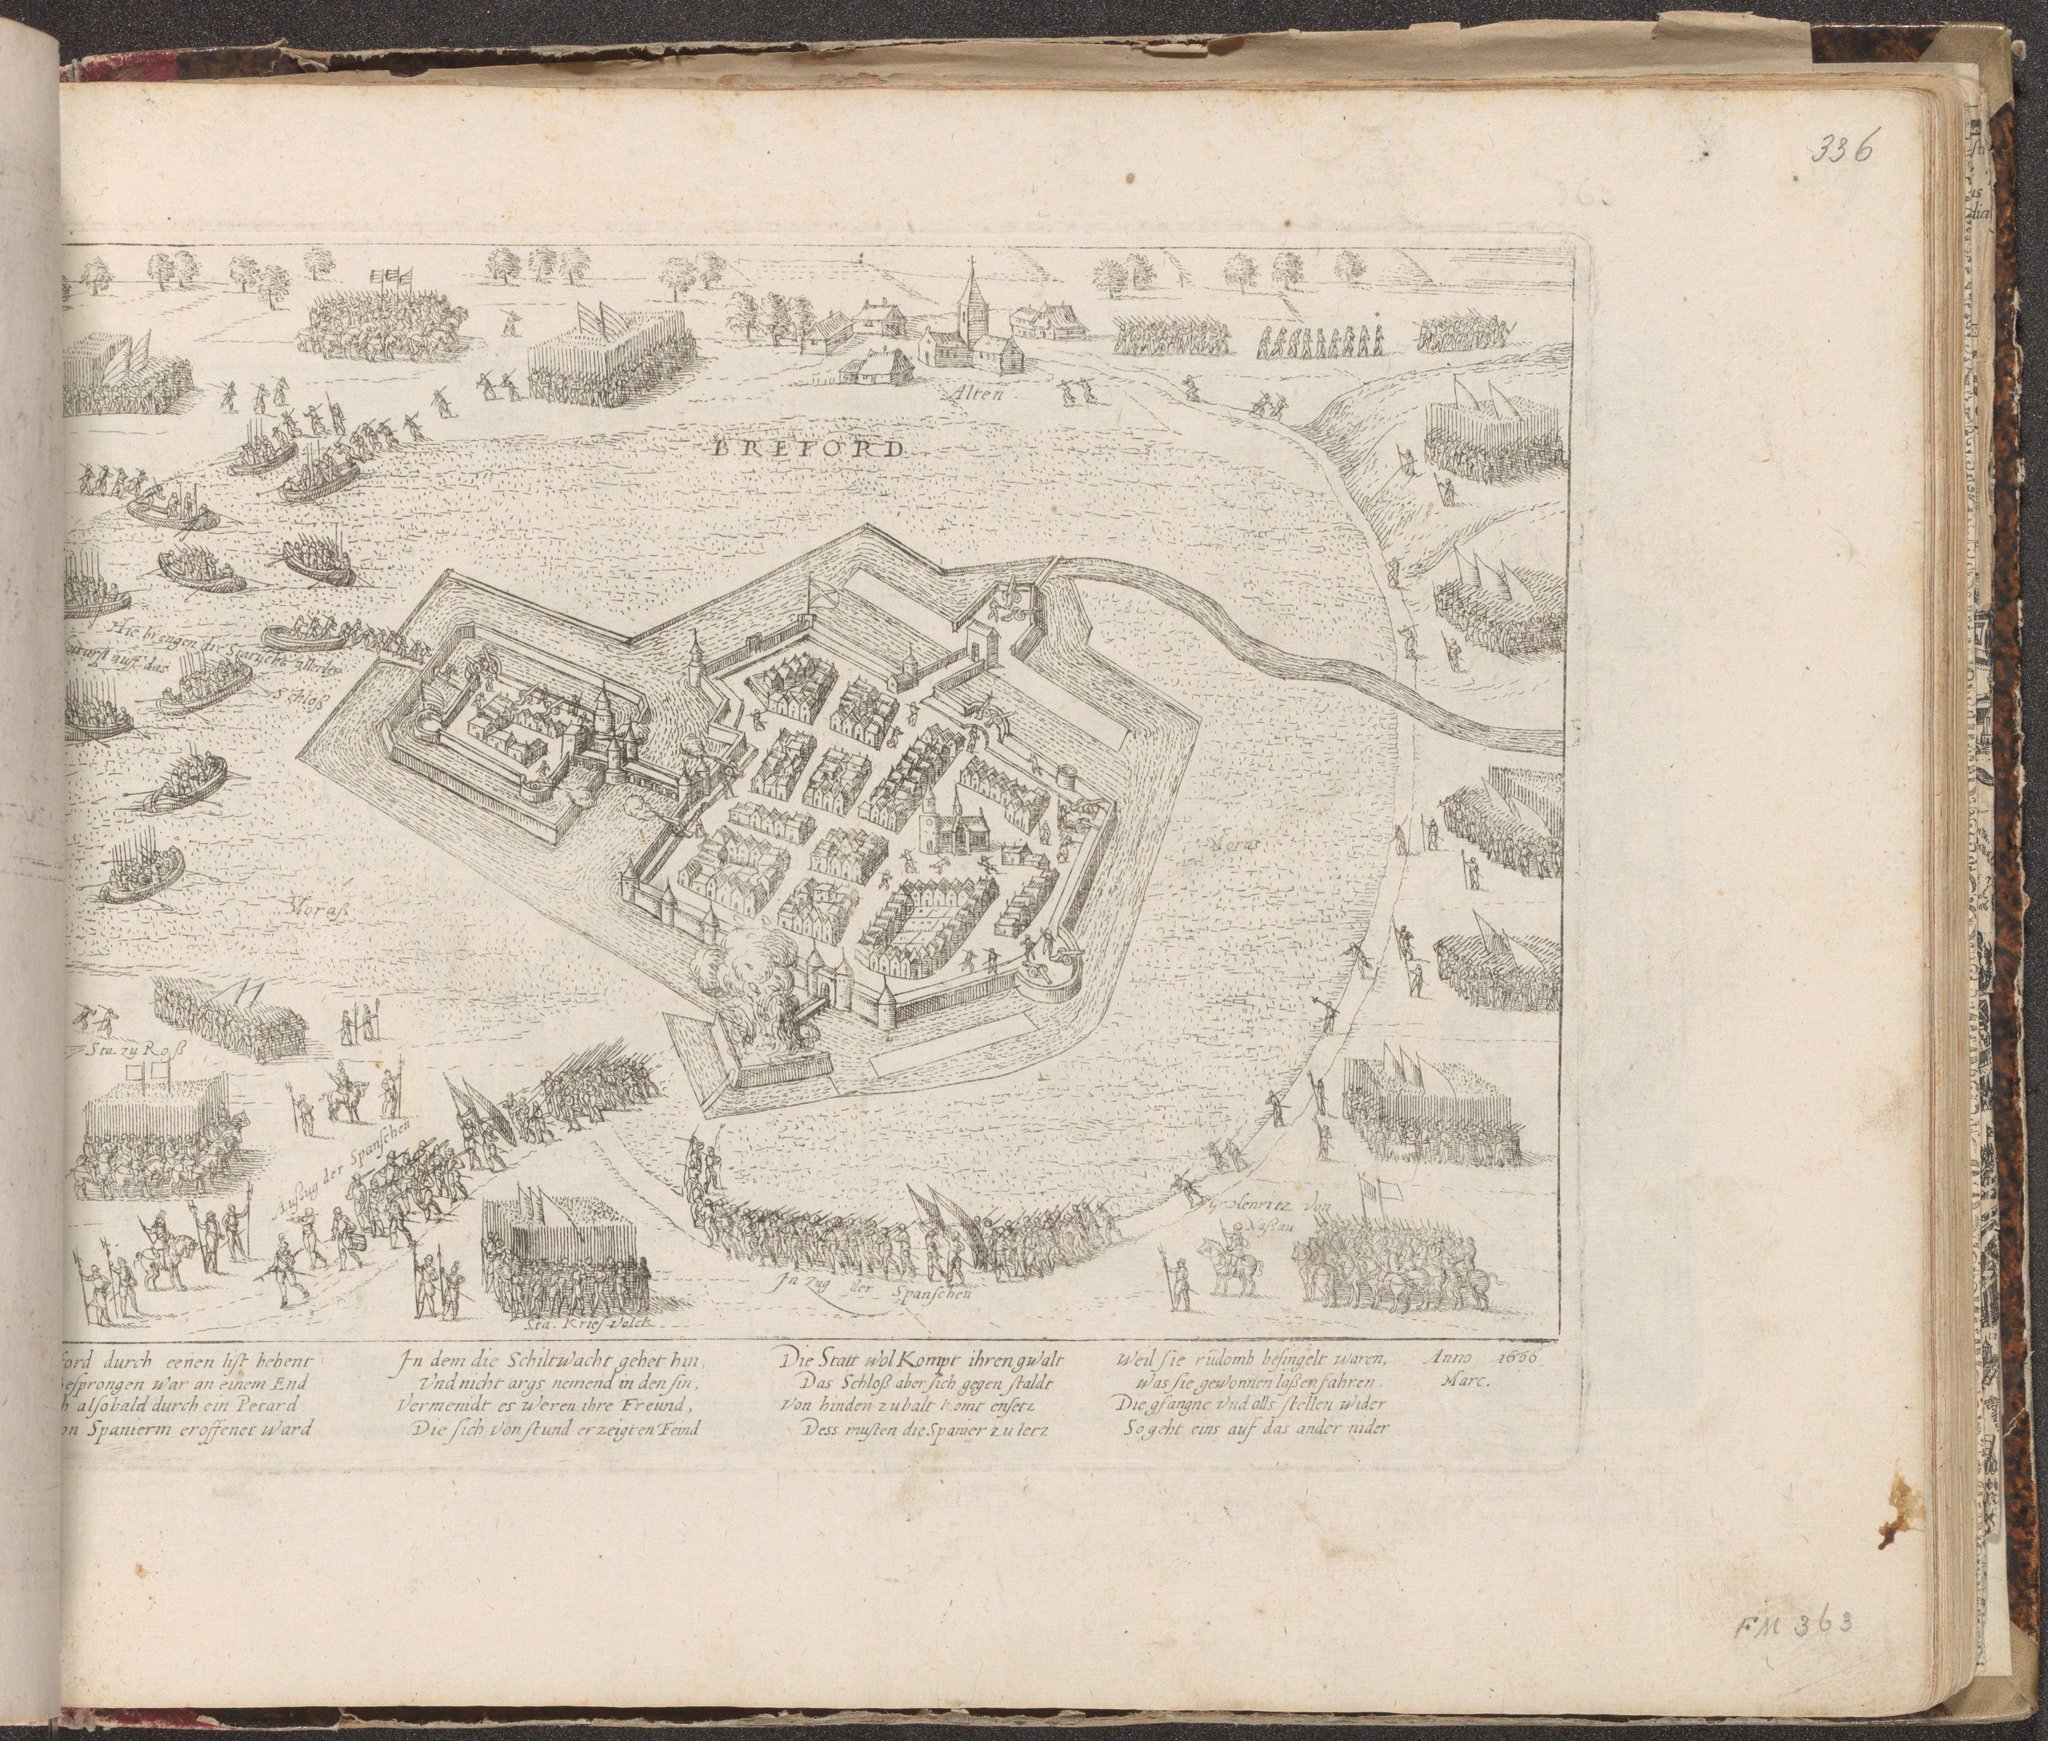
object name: print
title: Serie 10: Nederlandse en Buitenlandse Gebeurtenissen, 1587-1612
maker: frans hogenberg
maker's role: print maker, publisher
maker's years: 1538-1590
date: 1606-1608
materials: paper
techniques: etching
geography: cologne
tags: delft, the hague, frederick henry (prince of orange), raising the siege with outside assistance, relief, capture of city (after the siege)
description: Inname en ontzet van Bredevoort, 22 maart 1606. Onderaan nemen de Spanjaarden Bredevoort in, linksonder verlaten de Spanjaarden onder toeziend oog van leger van Frederik Hendrik de stad. Met onderschrift van 16 regels in het Duits. Linksonder genummerd: 359. De prent maakt deel uit van een album.